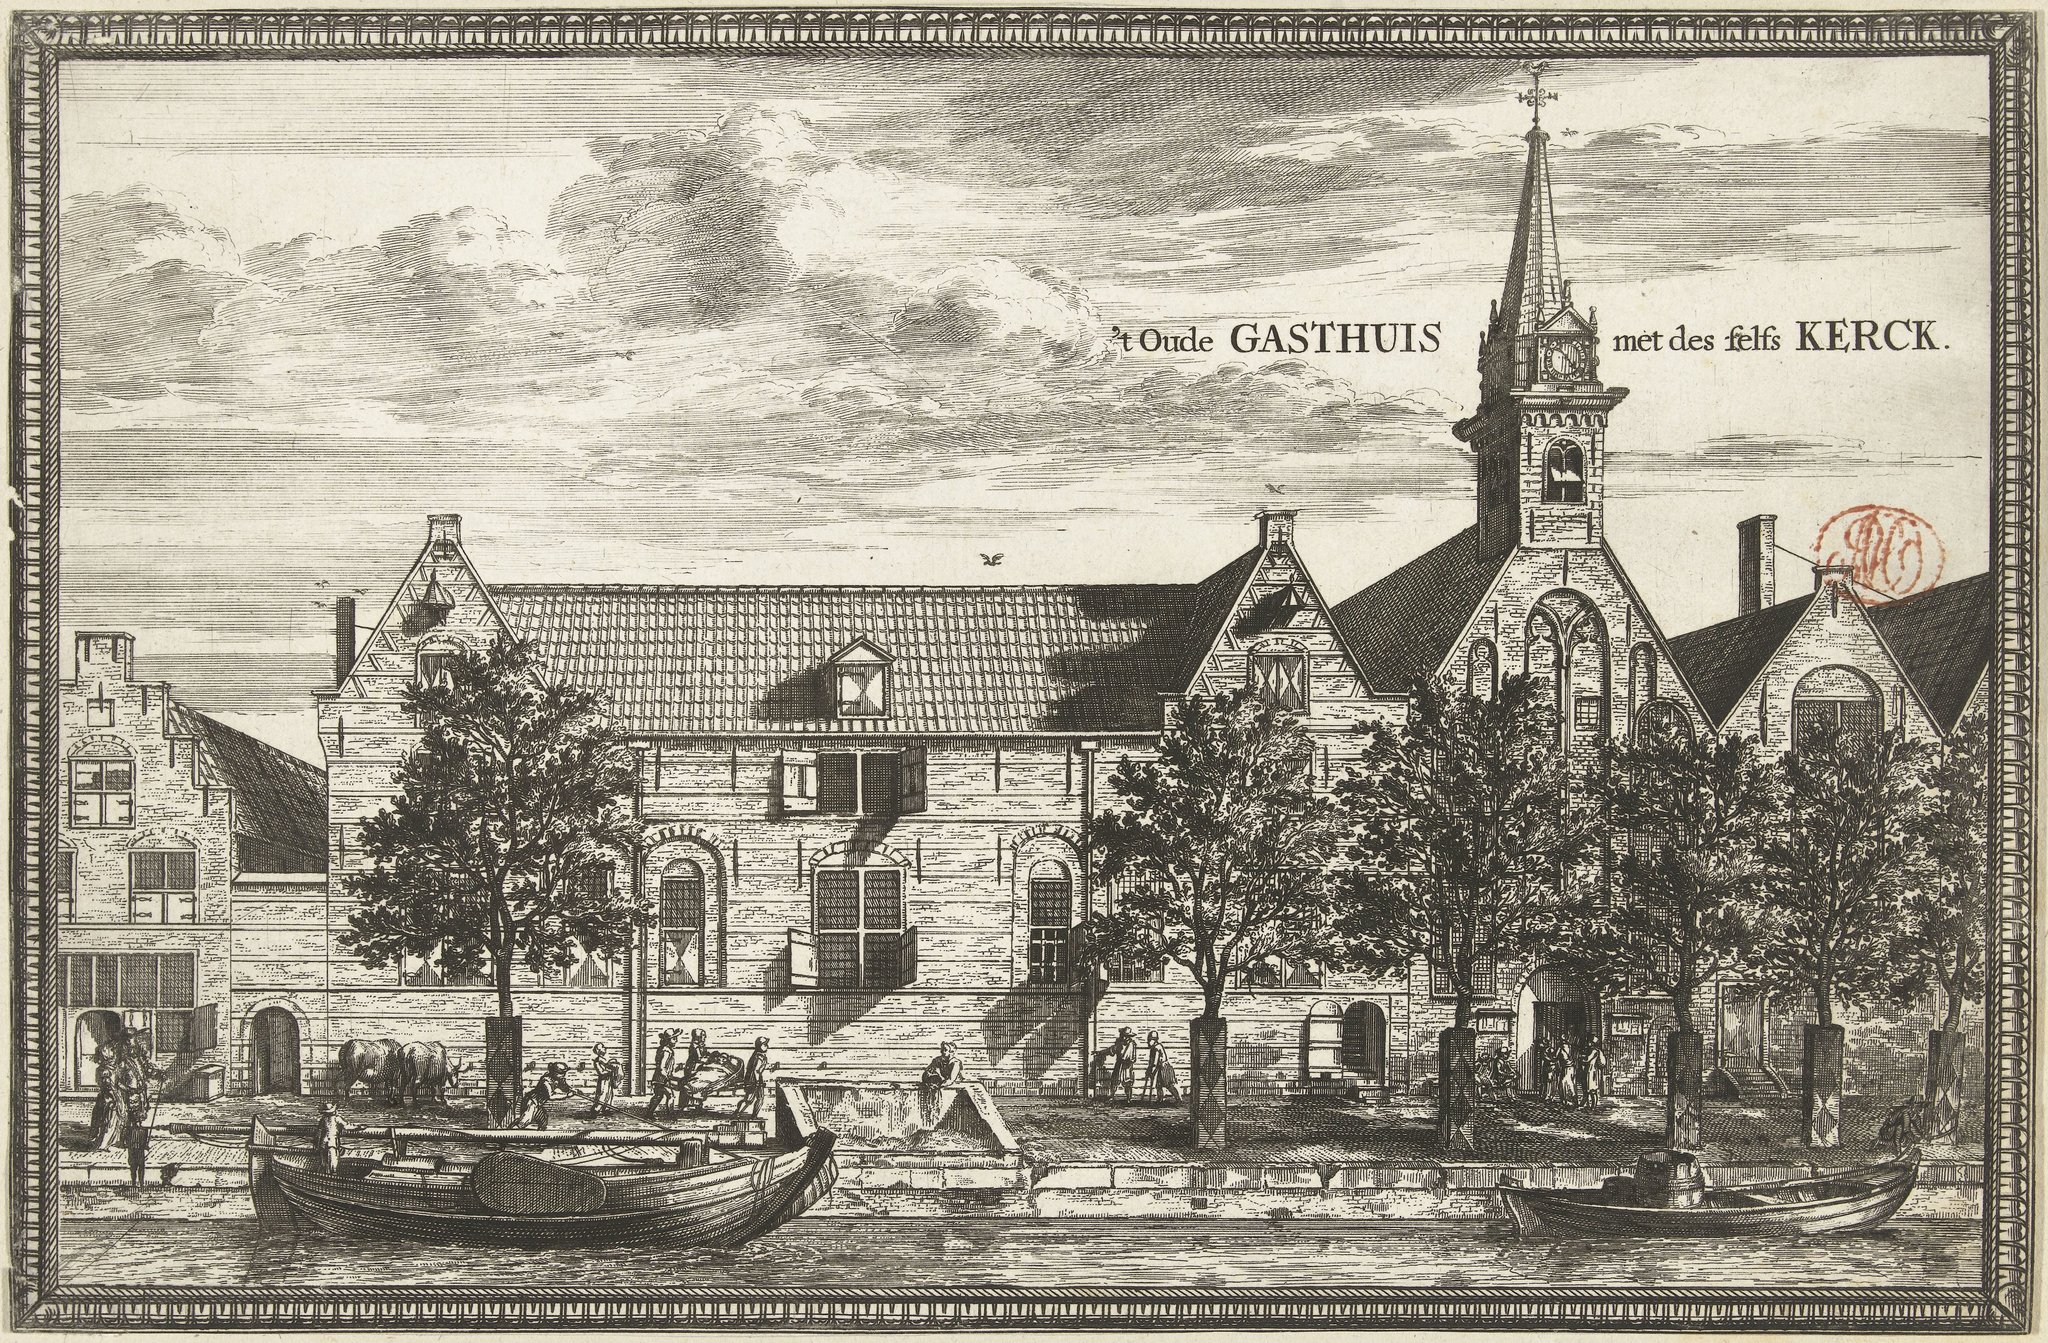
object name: print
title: 't Oude Gasthuis met des selfs kerck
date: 1678-1703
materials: paper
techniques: etching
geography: amsterdam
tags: church (exterior), hospital, delft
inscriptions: collector's mark: Lugt 195, collector's mark: Lugt 2228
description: Deze prent is in 1678 voor het eerst uitgegeven als onderdeel van de rand van de zogenaamde Kaart Figuratief (Caerte figuratyff / Kaerte figuratyf) van Delft, een wandkaart van Delft. Deze kaart bestaat uit een plattegrond van Delft (RP-P-AO-11-8A) met daaromheen een rand. De rand bestaat uit een profiel van Delft (RP-P-AO-11-11), een profiel van Delfshaven met daaronder de wapenschilden van de burgemeesters van de stad (RP-P-AO-13-51-1 en RP-P-AO-13-51-2), 24 kleinere prenten (kaarten, afbeeldingen van gebouwen en graven van bekende personen, o.a. huidige prent, RP-P-AO-11-15, RP-P-AO-11-16, RP-P-AO-11-17, RP-P-AO-11-18, RP-P-AO-11-19, RP-P-AO-11-20, RP-P-AO-11-21, RP-P-AO-11-23, RP-P-AO-11-24, RP-P-AO-11-28, RP-P-AO-11-29, RP-P-AO-11-30, RP-P-AO-11-31, RP-P-AO-11-33C, RP-P-AO-11-34, RP-P-AO-11-35, RP-P-AO-11-35-2, RP-P-AO-13-49, RP-P-AO-13-52, RP-P-AO-13-53, RP-P-AO-13-54-1 en RP-P-1909-6463) en een beschrijving van de stad (RP-P-AO-11-8E). De eerste druk van deze Kaart Figuratief (1678) werd, in opdracht van het Delftse stadsbestuur, verzorgd door Pieter Smith. In 1680 leverde Smith ook vijfhonderd afdrukken van de randprenten die bestemd waren voor Dirk Evertsz. Bleyswijcks 'Beschryvinge der stadt Delft' (1667) en het tweede deel: 'Vervolg van de beschryvinge der stadt Delft' (1680). In het tweede deel zat een bijlage waarin beschreven staat welke prenten waar in het eerste en tweede deel ingebonden dienden te worden. Een deel van de prenten was dus bestemd voor het in 1667 verschenen eerste deel en kon met het verschijnen van het tweede deel in 1680 alsnog worden ingebonden. Hierdoor wordt vaak gedacht dat de prenten uit het eerste deel dateren uit 1667, hetgeen niet klopt. De huidige prent is zodoende ook gebruikt in: Bleyswijck, Dirk Evertsz. Beschryvinge der stadt Delft, betreffende des selfs situatie, oorsprong en ouderdom, opkomst en voortgangh (…). Delft: Arnold Bon, 1667 (prenten vanaf 1680 ingebonden), p. 288. Pieter Mortier (I) verzorgde in 1703, tevens in opdracht van het stadsbestuur, een tweede uitgave van de Kaart Figuratief. Voor deze druk bracht graveur Thomas van der Wilt enkele aanpassingen aan op de platen van de plattegrond. De randplaten lijken, op de plaat met de wapens van de burgemeesters na, ongewijzigd te zijn gebleven. De plattegrond is in 1752, waarschijnlijk zonder de randprenten, opnieuw uitgegeven. Een deel van de randprenten, waaronder de huidige prent, is in 1729 opnieuw gebruikt in: Beschryving der stadt Delft, behelzende een zeer naaukeurige en uitvoerige verhandeling van deszelfs eerste oorsprong (…). Delft: Reinier Boitet, 1729. Op twee na (die van de Nieuwe en Oude Kerk) paste Boitet de platen aan, waardoor van deze prenten een tweede staat ontstond. Of de huidige prent is gebruikt als onderdeel van de rand van de Kaart Figuratief uit 1678 of 1703, of is gebruikt in 'Beschryvinge der stadt Delft' (1667, prenten 1680), is niet na te gaan.